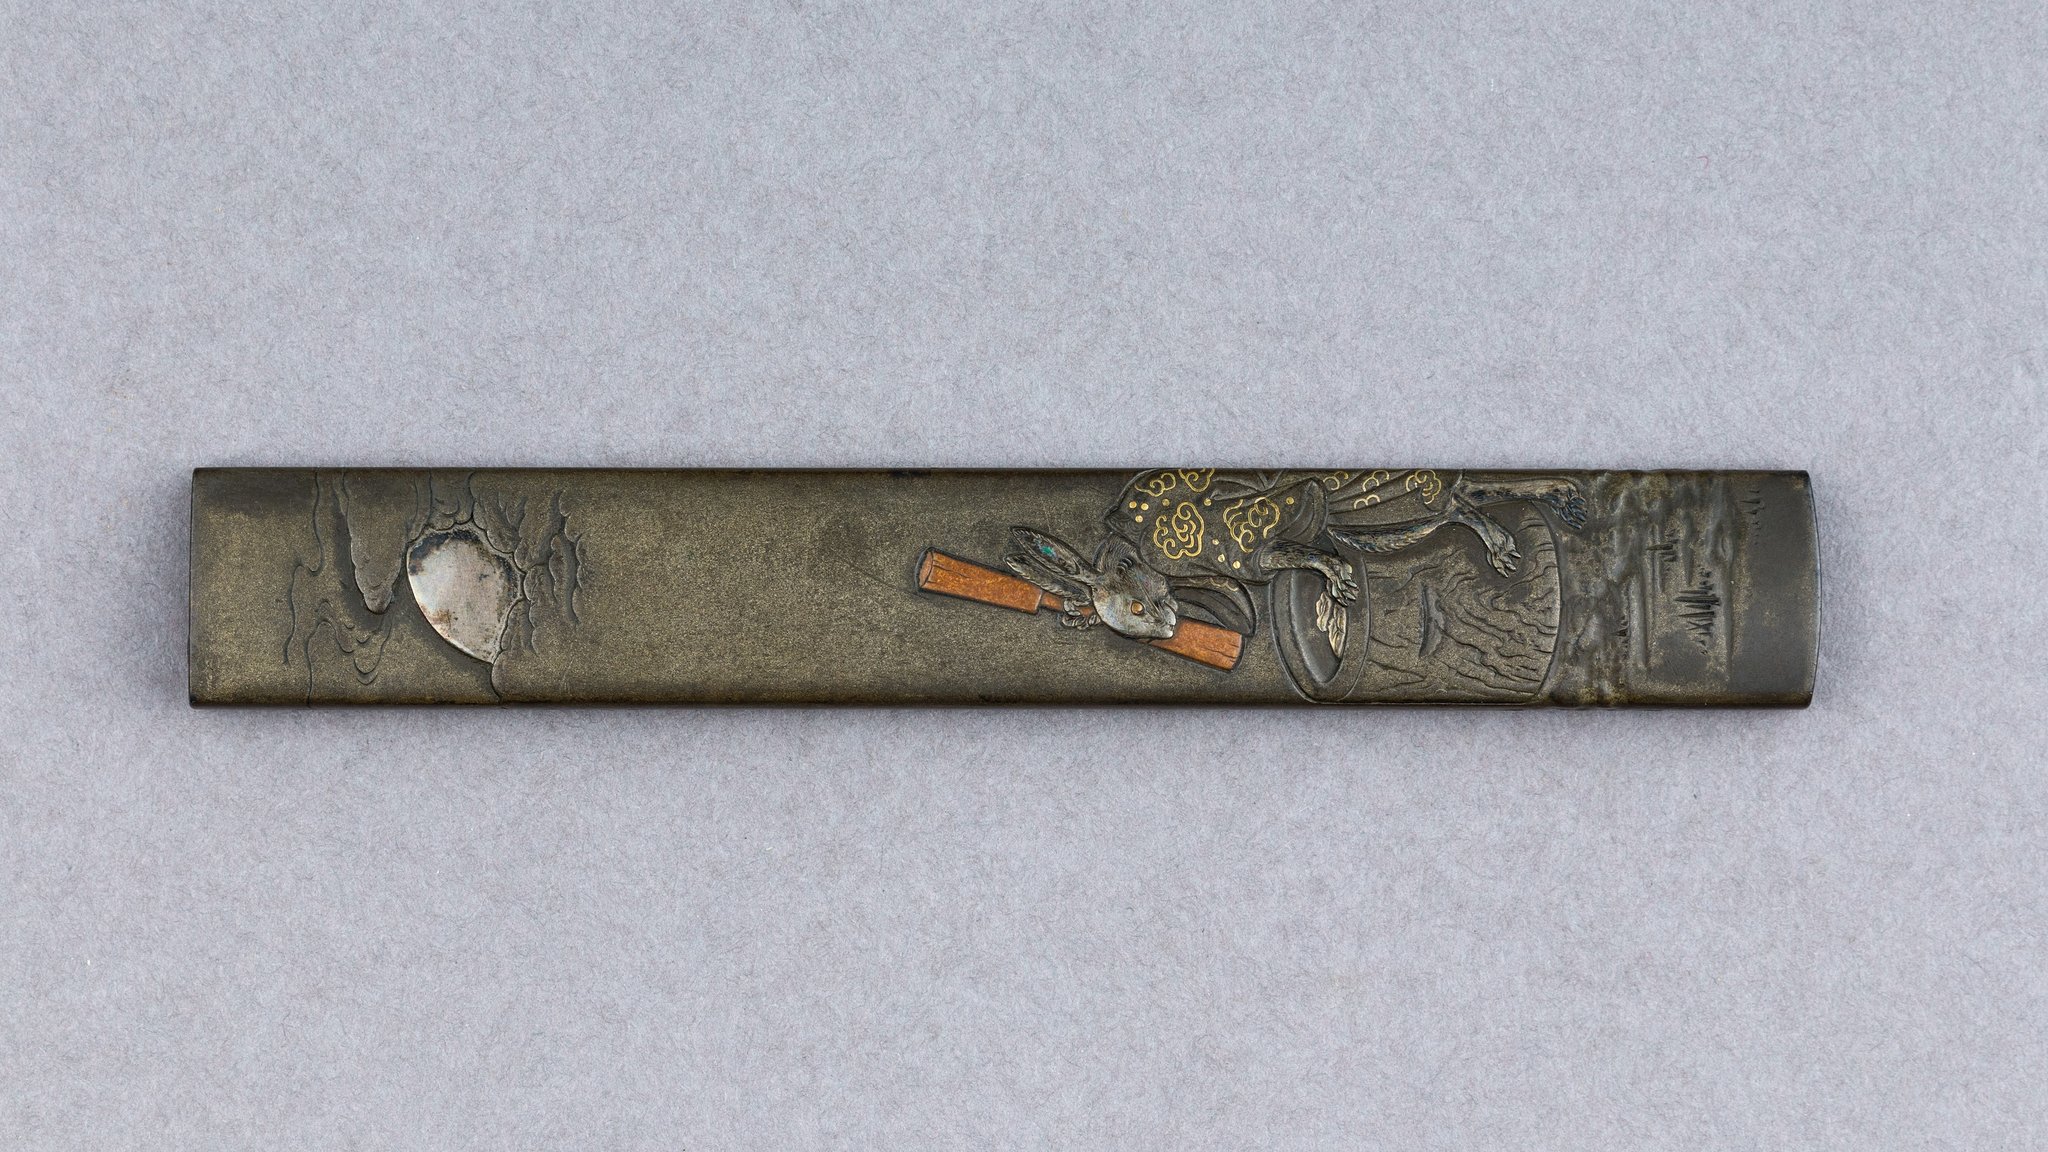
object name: knife handle kozuka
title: Knife Handle (Kozuka)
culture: japanese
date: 1615-1868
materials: copper, silver alloy, gold, silver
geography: japan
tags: rabbits